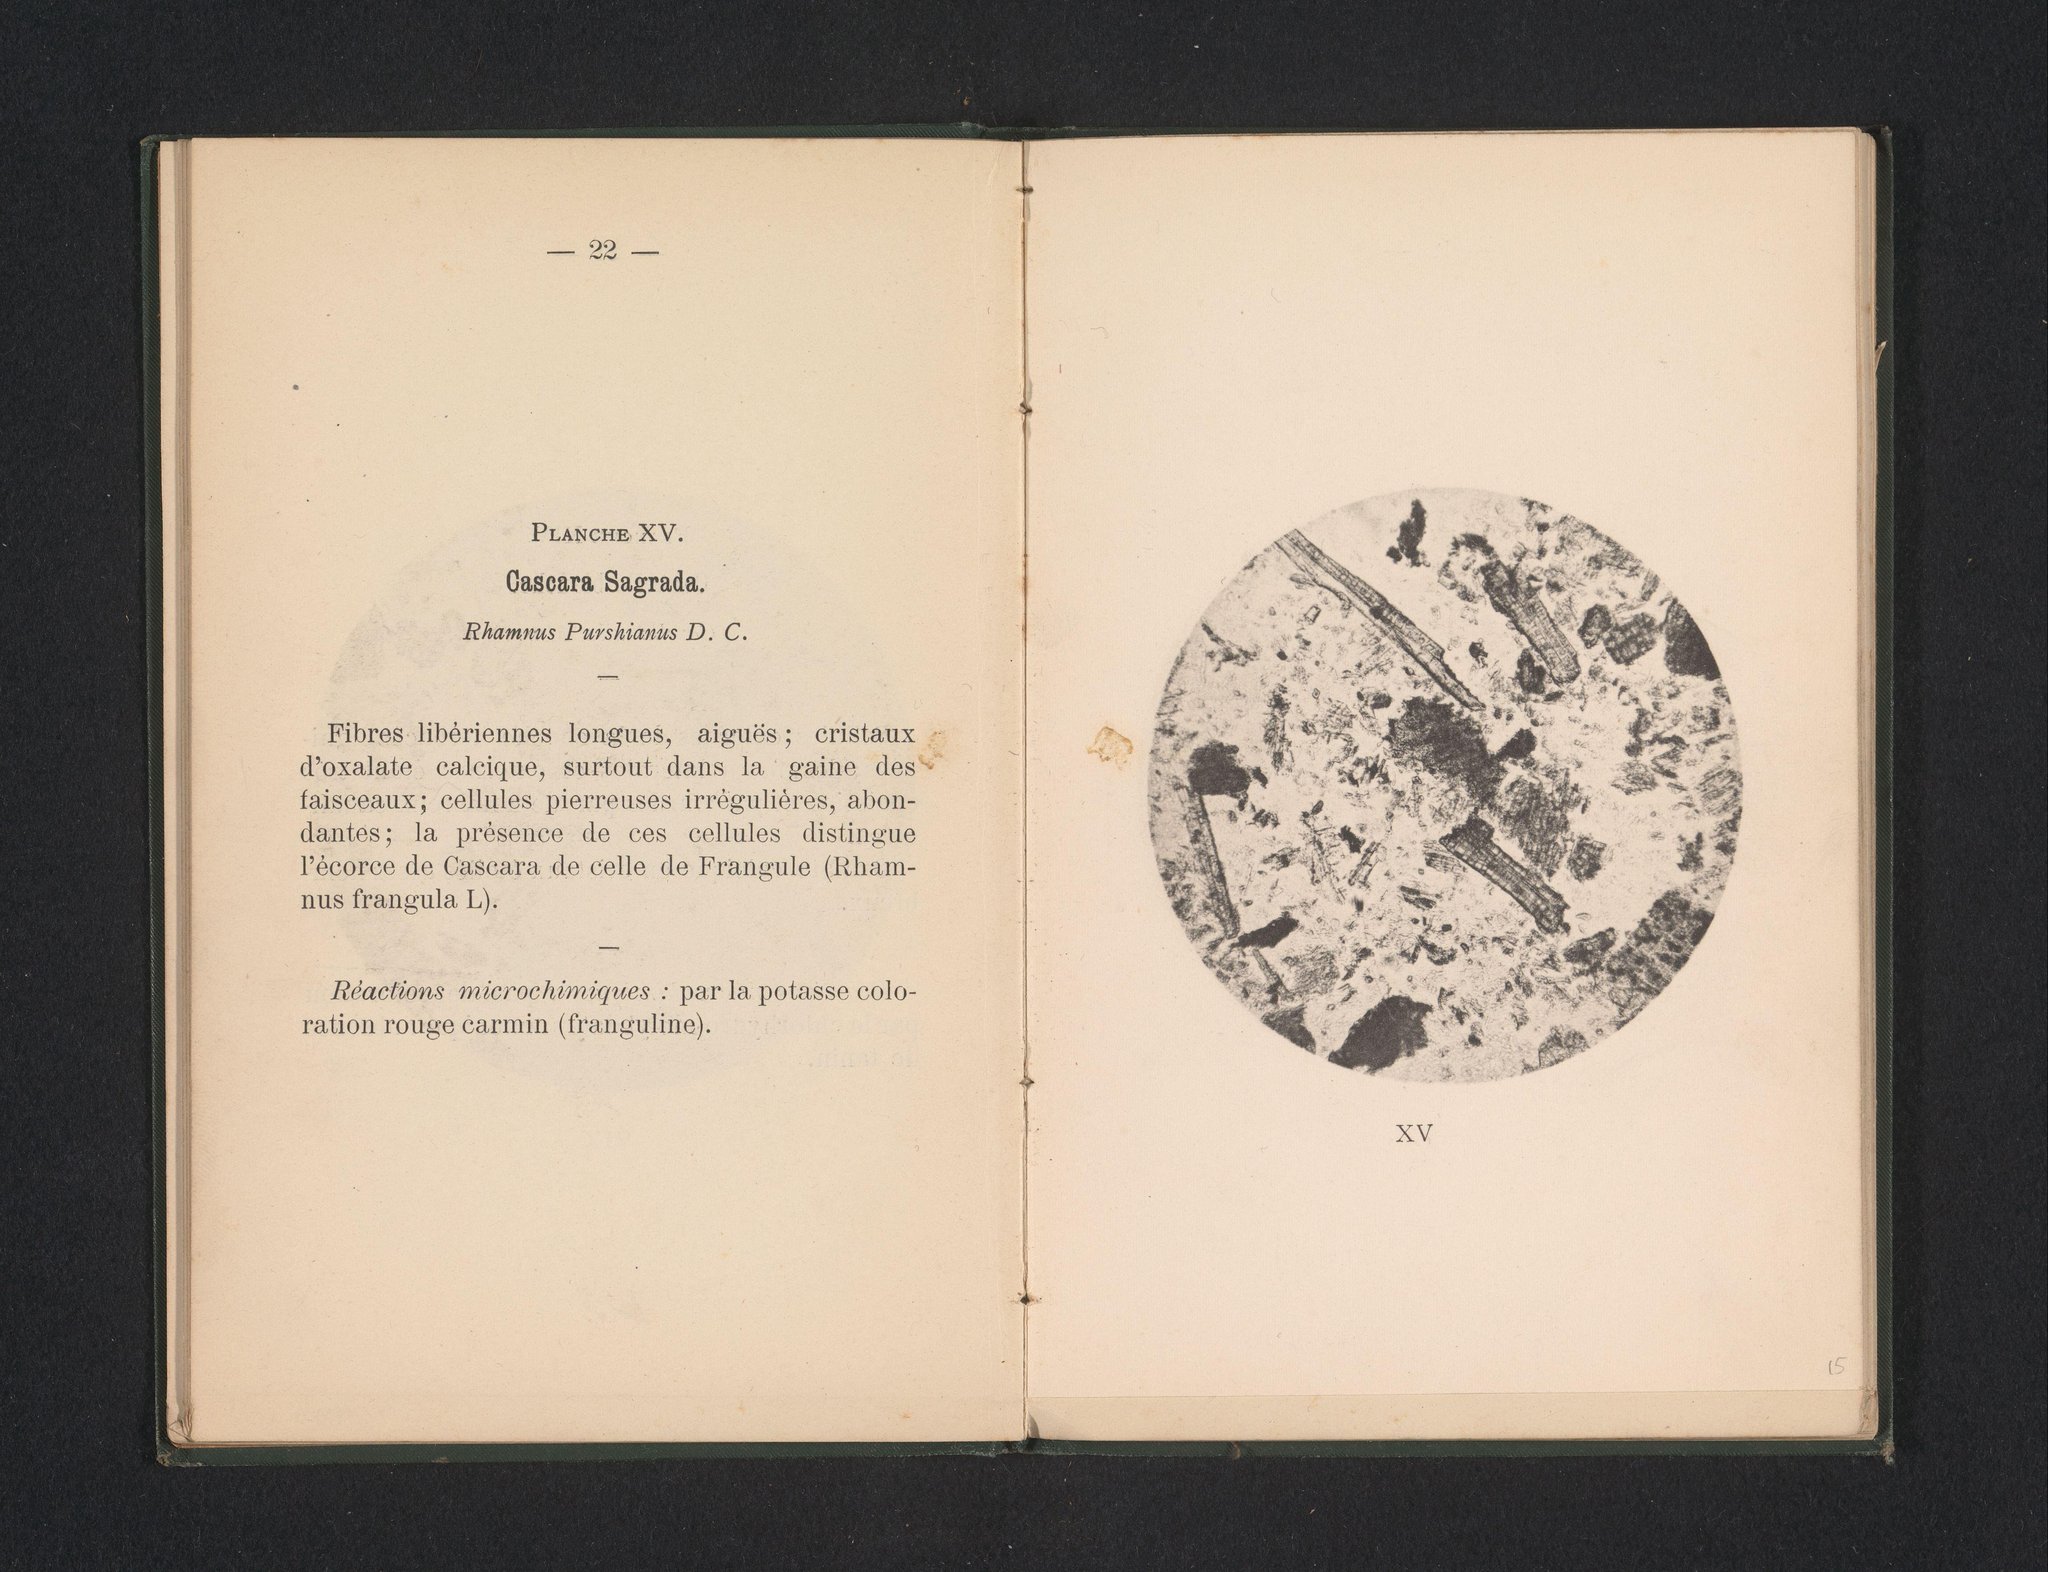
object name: page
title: Microscopische weergave van rhamnus purshianus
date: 1891-1896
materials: paper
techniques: photograph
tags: microscope (+ scientific research)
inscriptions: number: ‘XV’